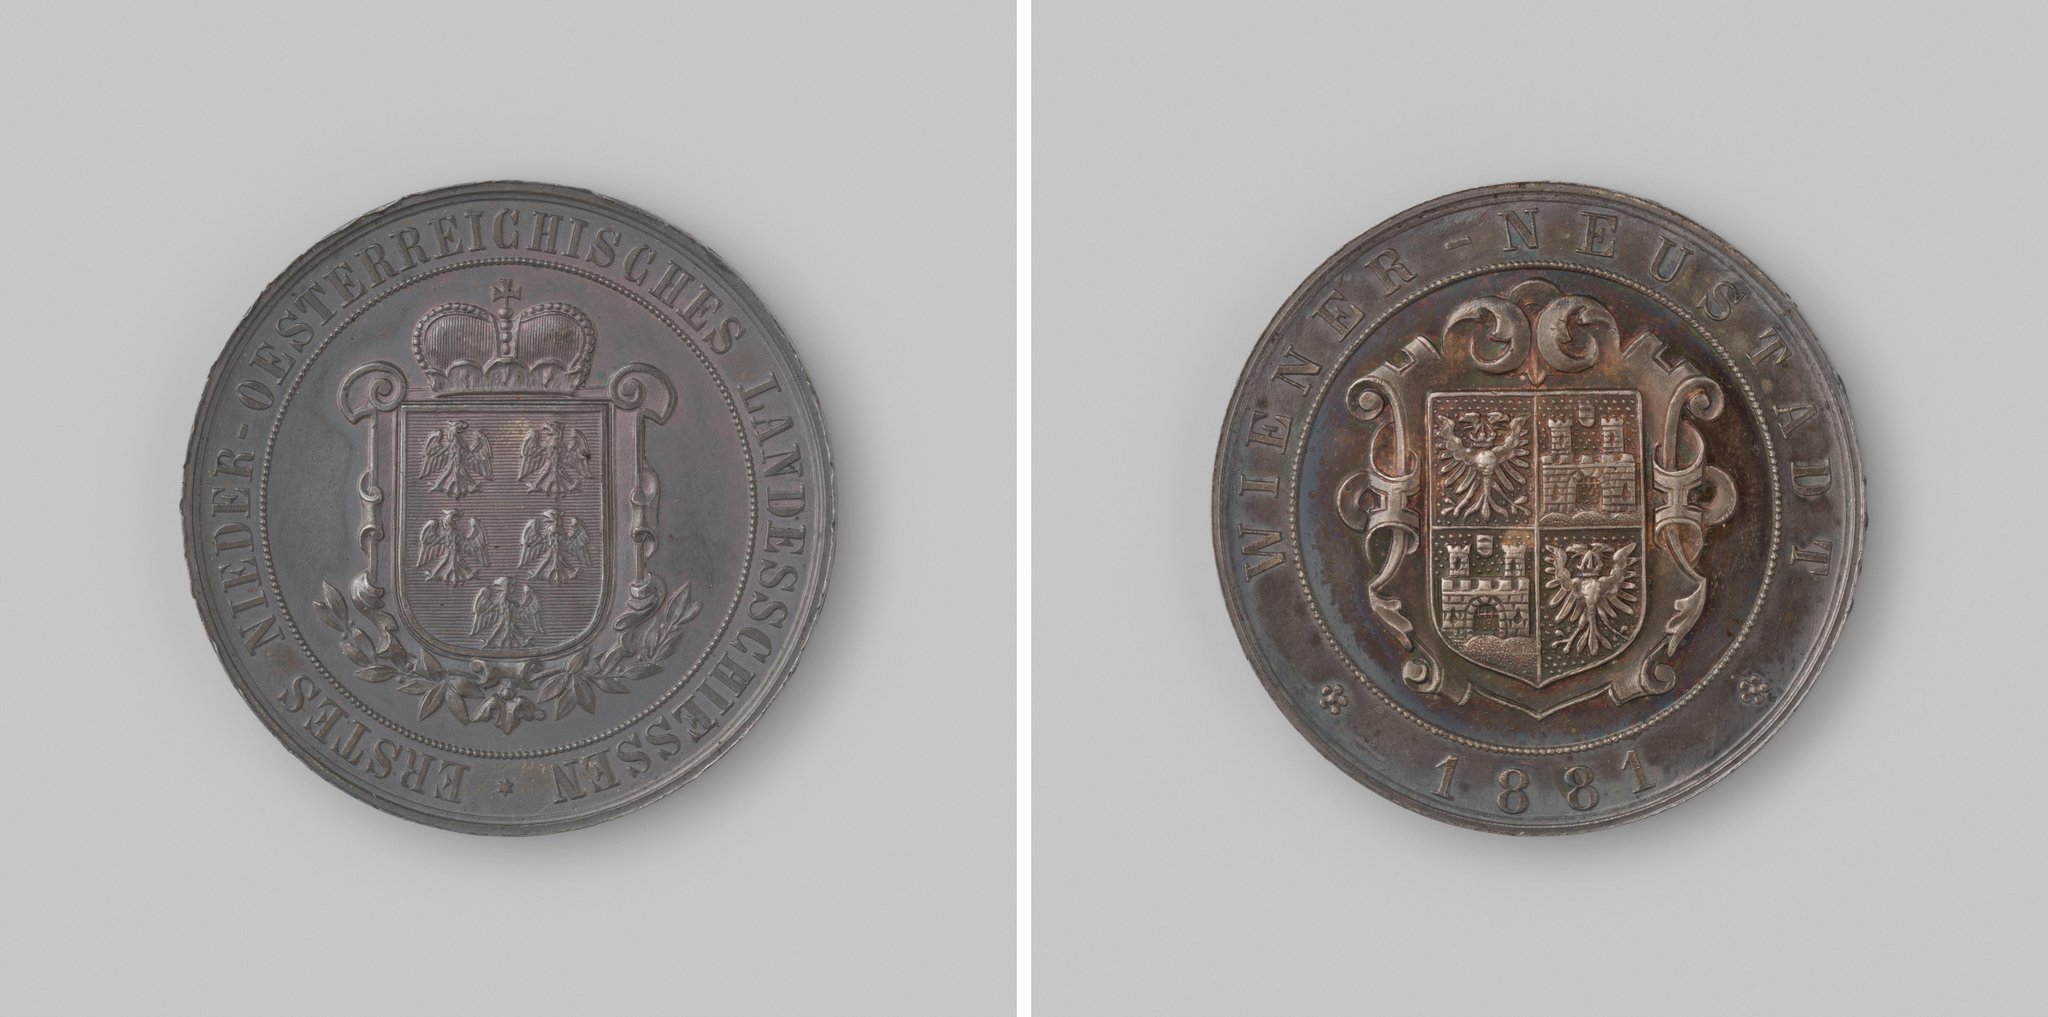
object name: history medal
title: Eerste Neder-Oostenrijkse schietwedstrijd in Wiener-Neustadt 1881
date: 1881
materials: silver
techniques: striking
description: Zilveren penning, op de voorzijde een gekroond wapenschild op lauwertakken, met omschrift, op de keerzijde een gevierendeeld wapenschild in een versierde cartouche, met omschrift.